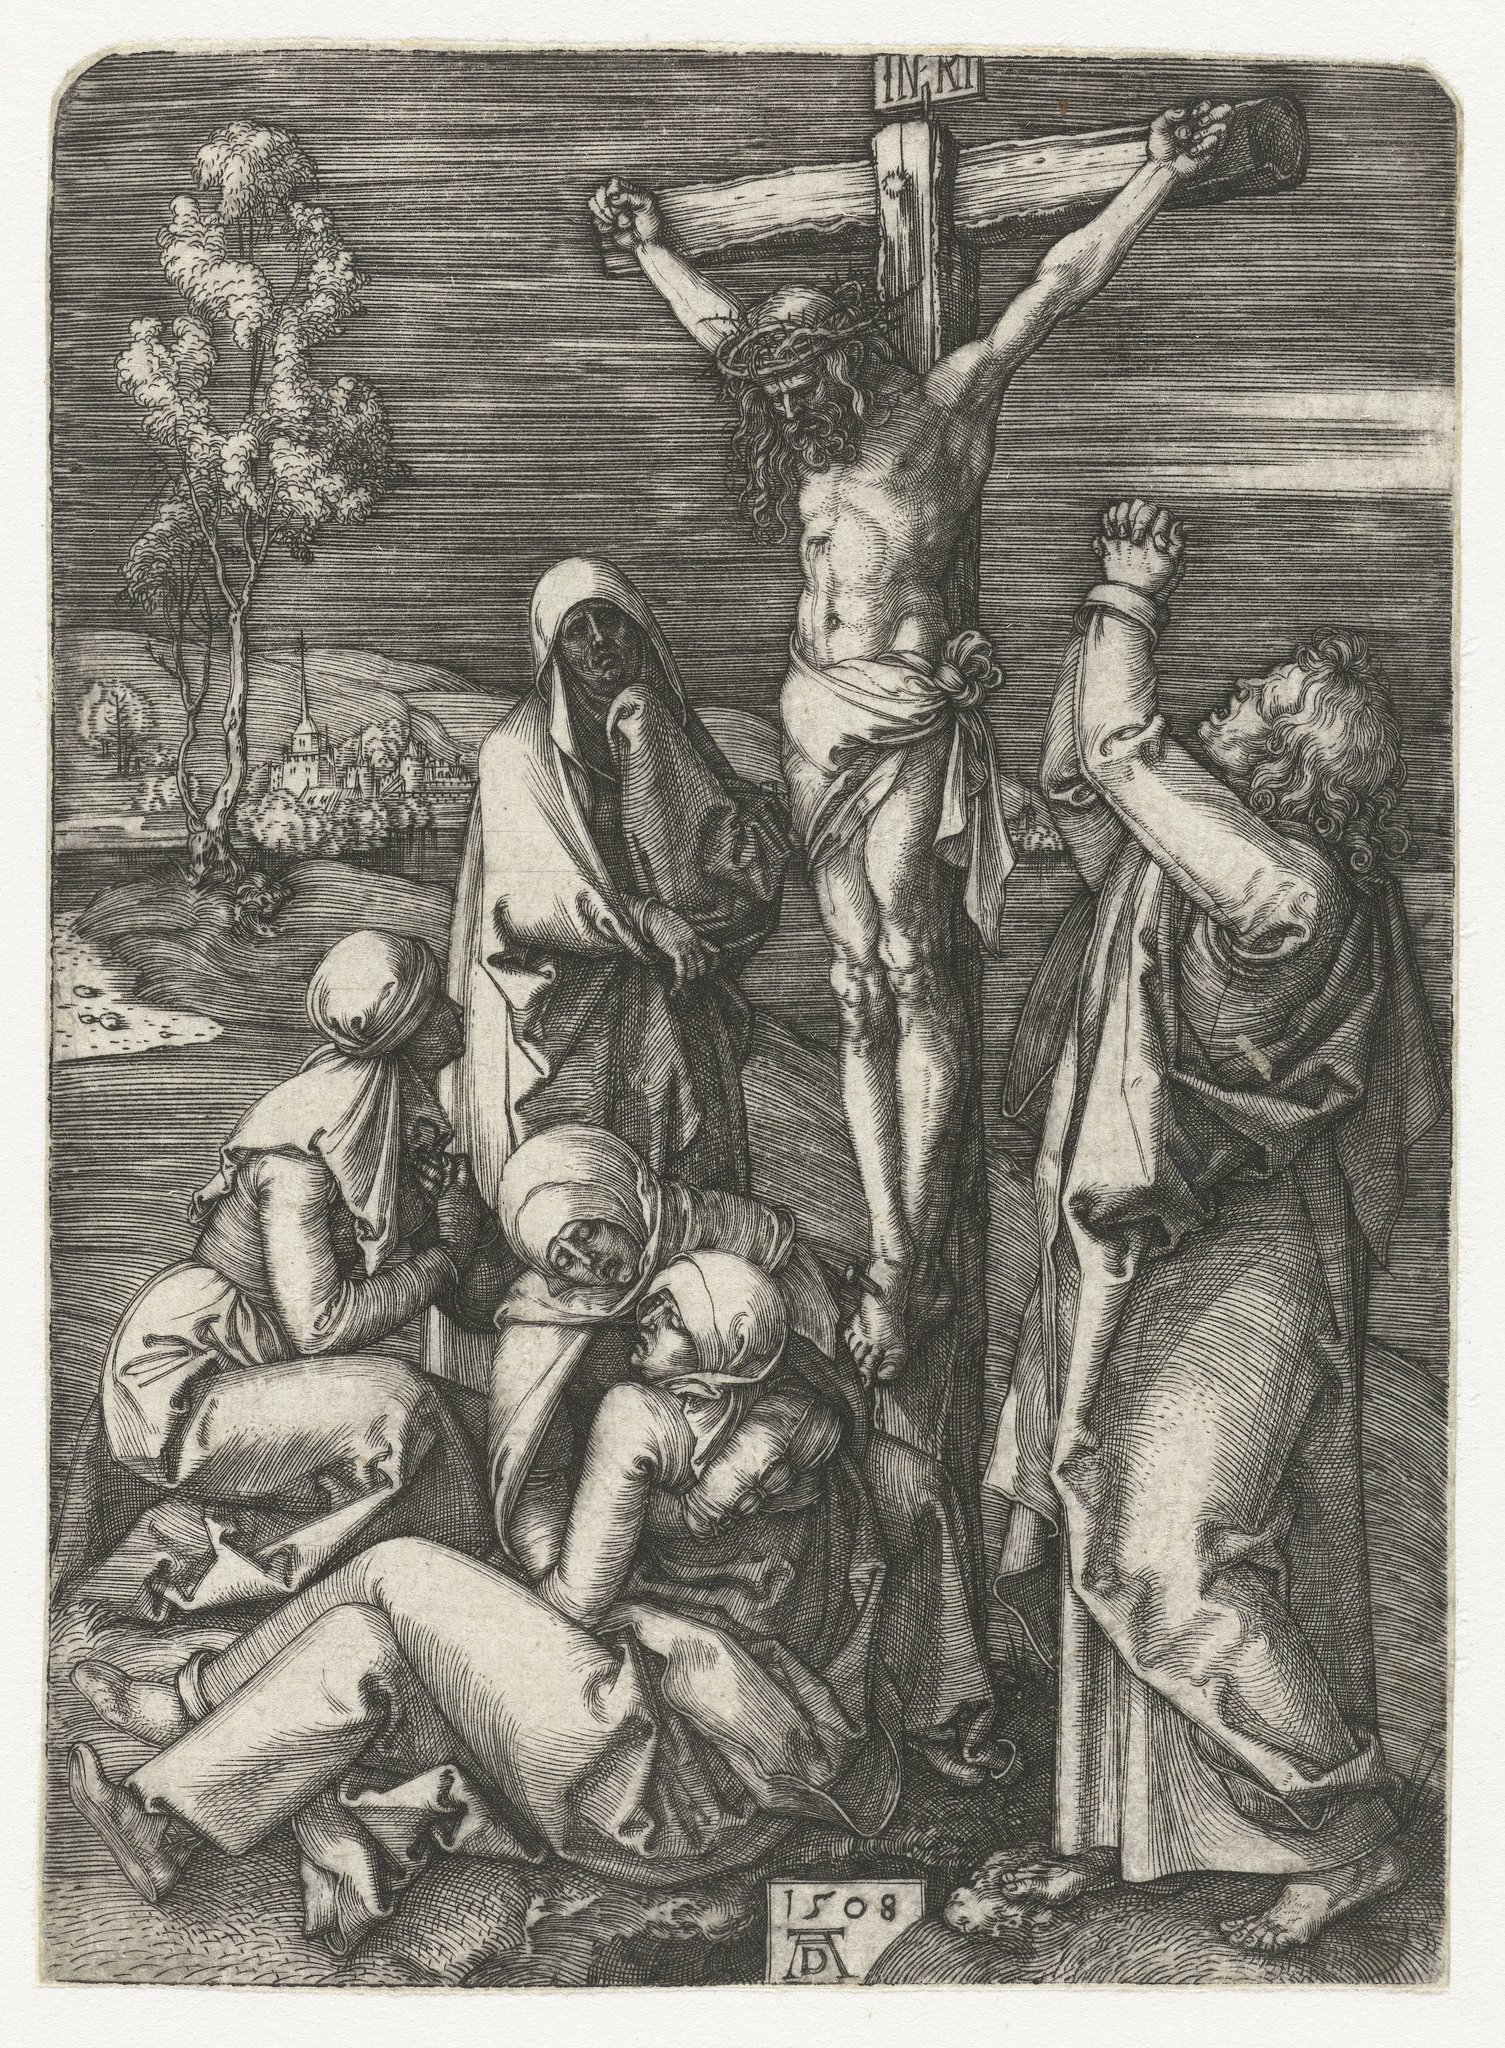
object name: print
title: De kruisiging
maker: albrecht dürer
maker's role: draughtsman, painter, print maker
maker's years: 1471-1528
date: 1508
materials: paper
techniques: engraving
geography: nuremberg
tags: crucified christ with mary, john, and mary magdalene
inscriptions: collector's mark: Lugt 240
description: Christus aan het kruis. Aan zijn linkerzijde staat Johannes de evangelist met de handen geheven in een biddend gebaar, aan zijn rechterzijde staan en zitten vier treurende vrouwen.